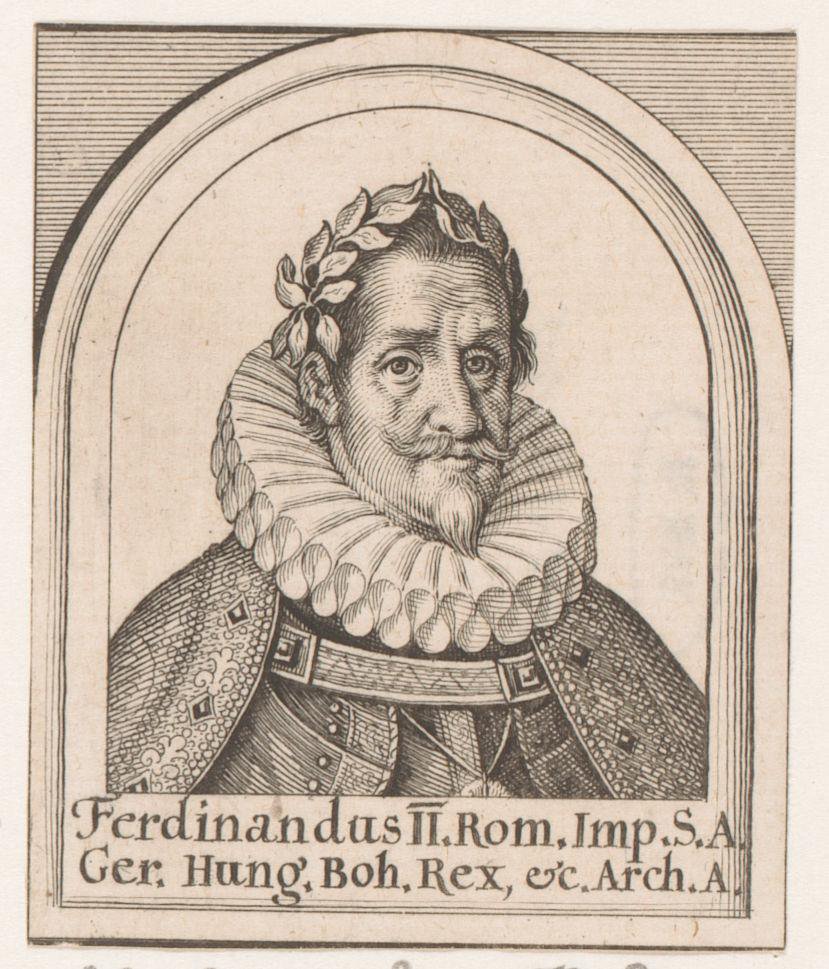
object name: print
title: Ferdinandus II. Rom. Imp. S.A. Ger. Hung. Boh. Rex, &c. Arch. A.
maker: matthäus merian (i)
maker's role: print maker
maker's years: 1593-1650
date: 1603-1650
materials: paper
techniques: engraving, etching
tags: vienna, ferdinand ii (duits keizer), garland, wreath, historical persons